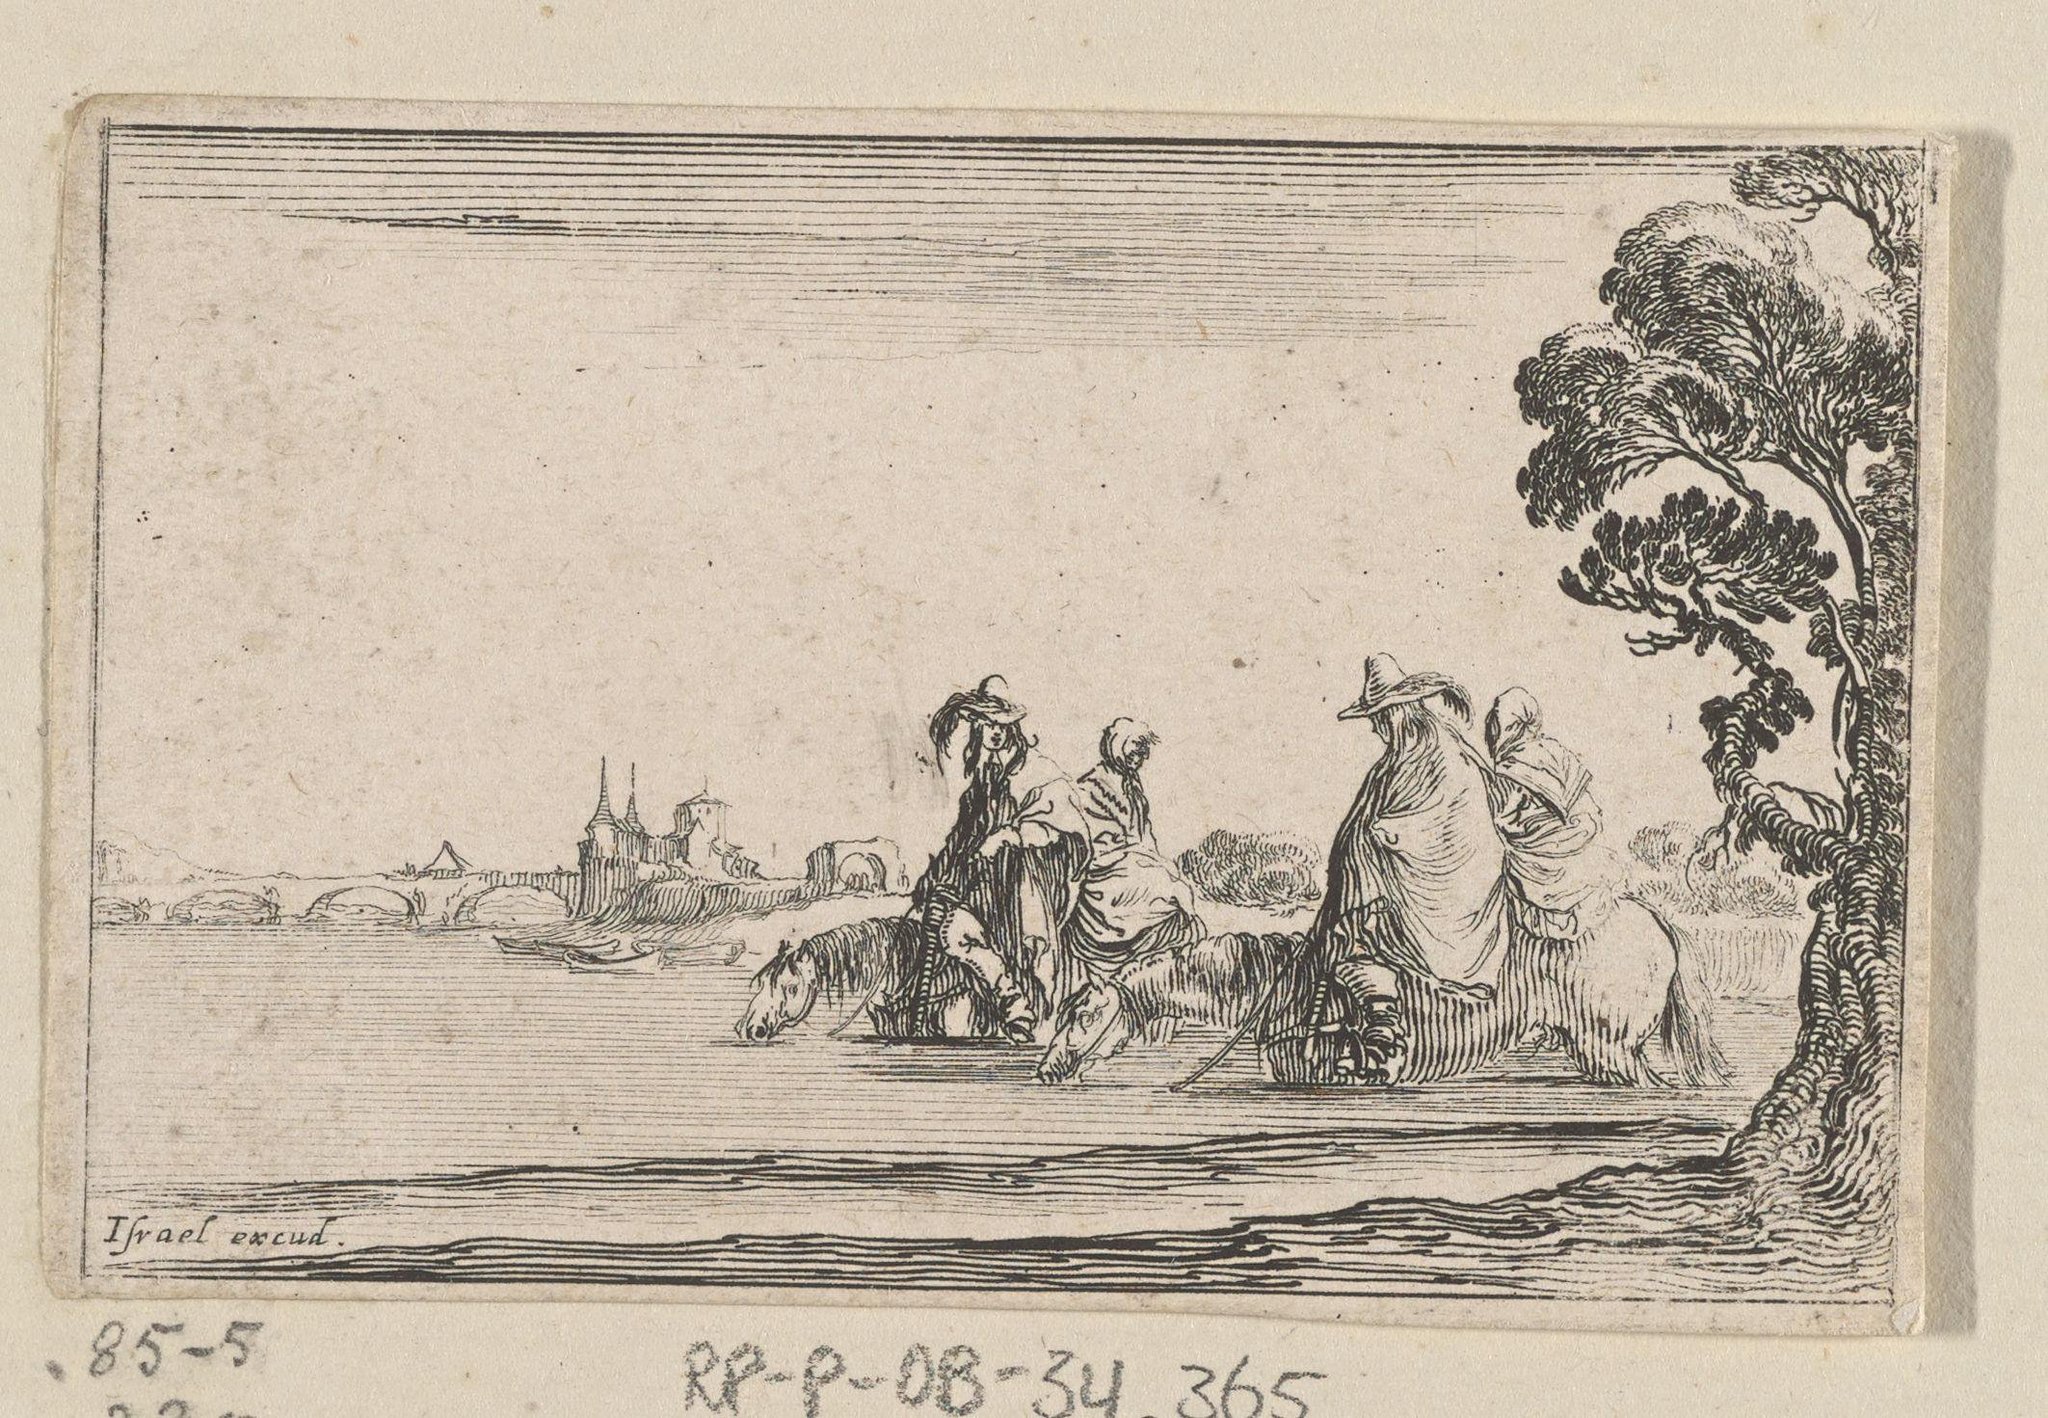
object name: print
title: Diverse voorstellingen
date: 1620-1664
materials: paper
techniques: etching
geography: paris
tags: riding a horse, ass, or mule; rider, horseman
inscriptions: collector's mark: Lugt 240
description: Prent uit een reeks van 13 prenten inclusief titelprent.